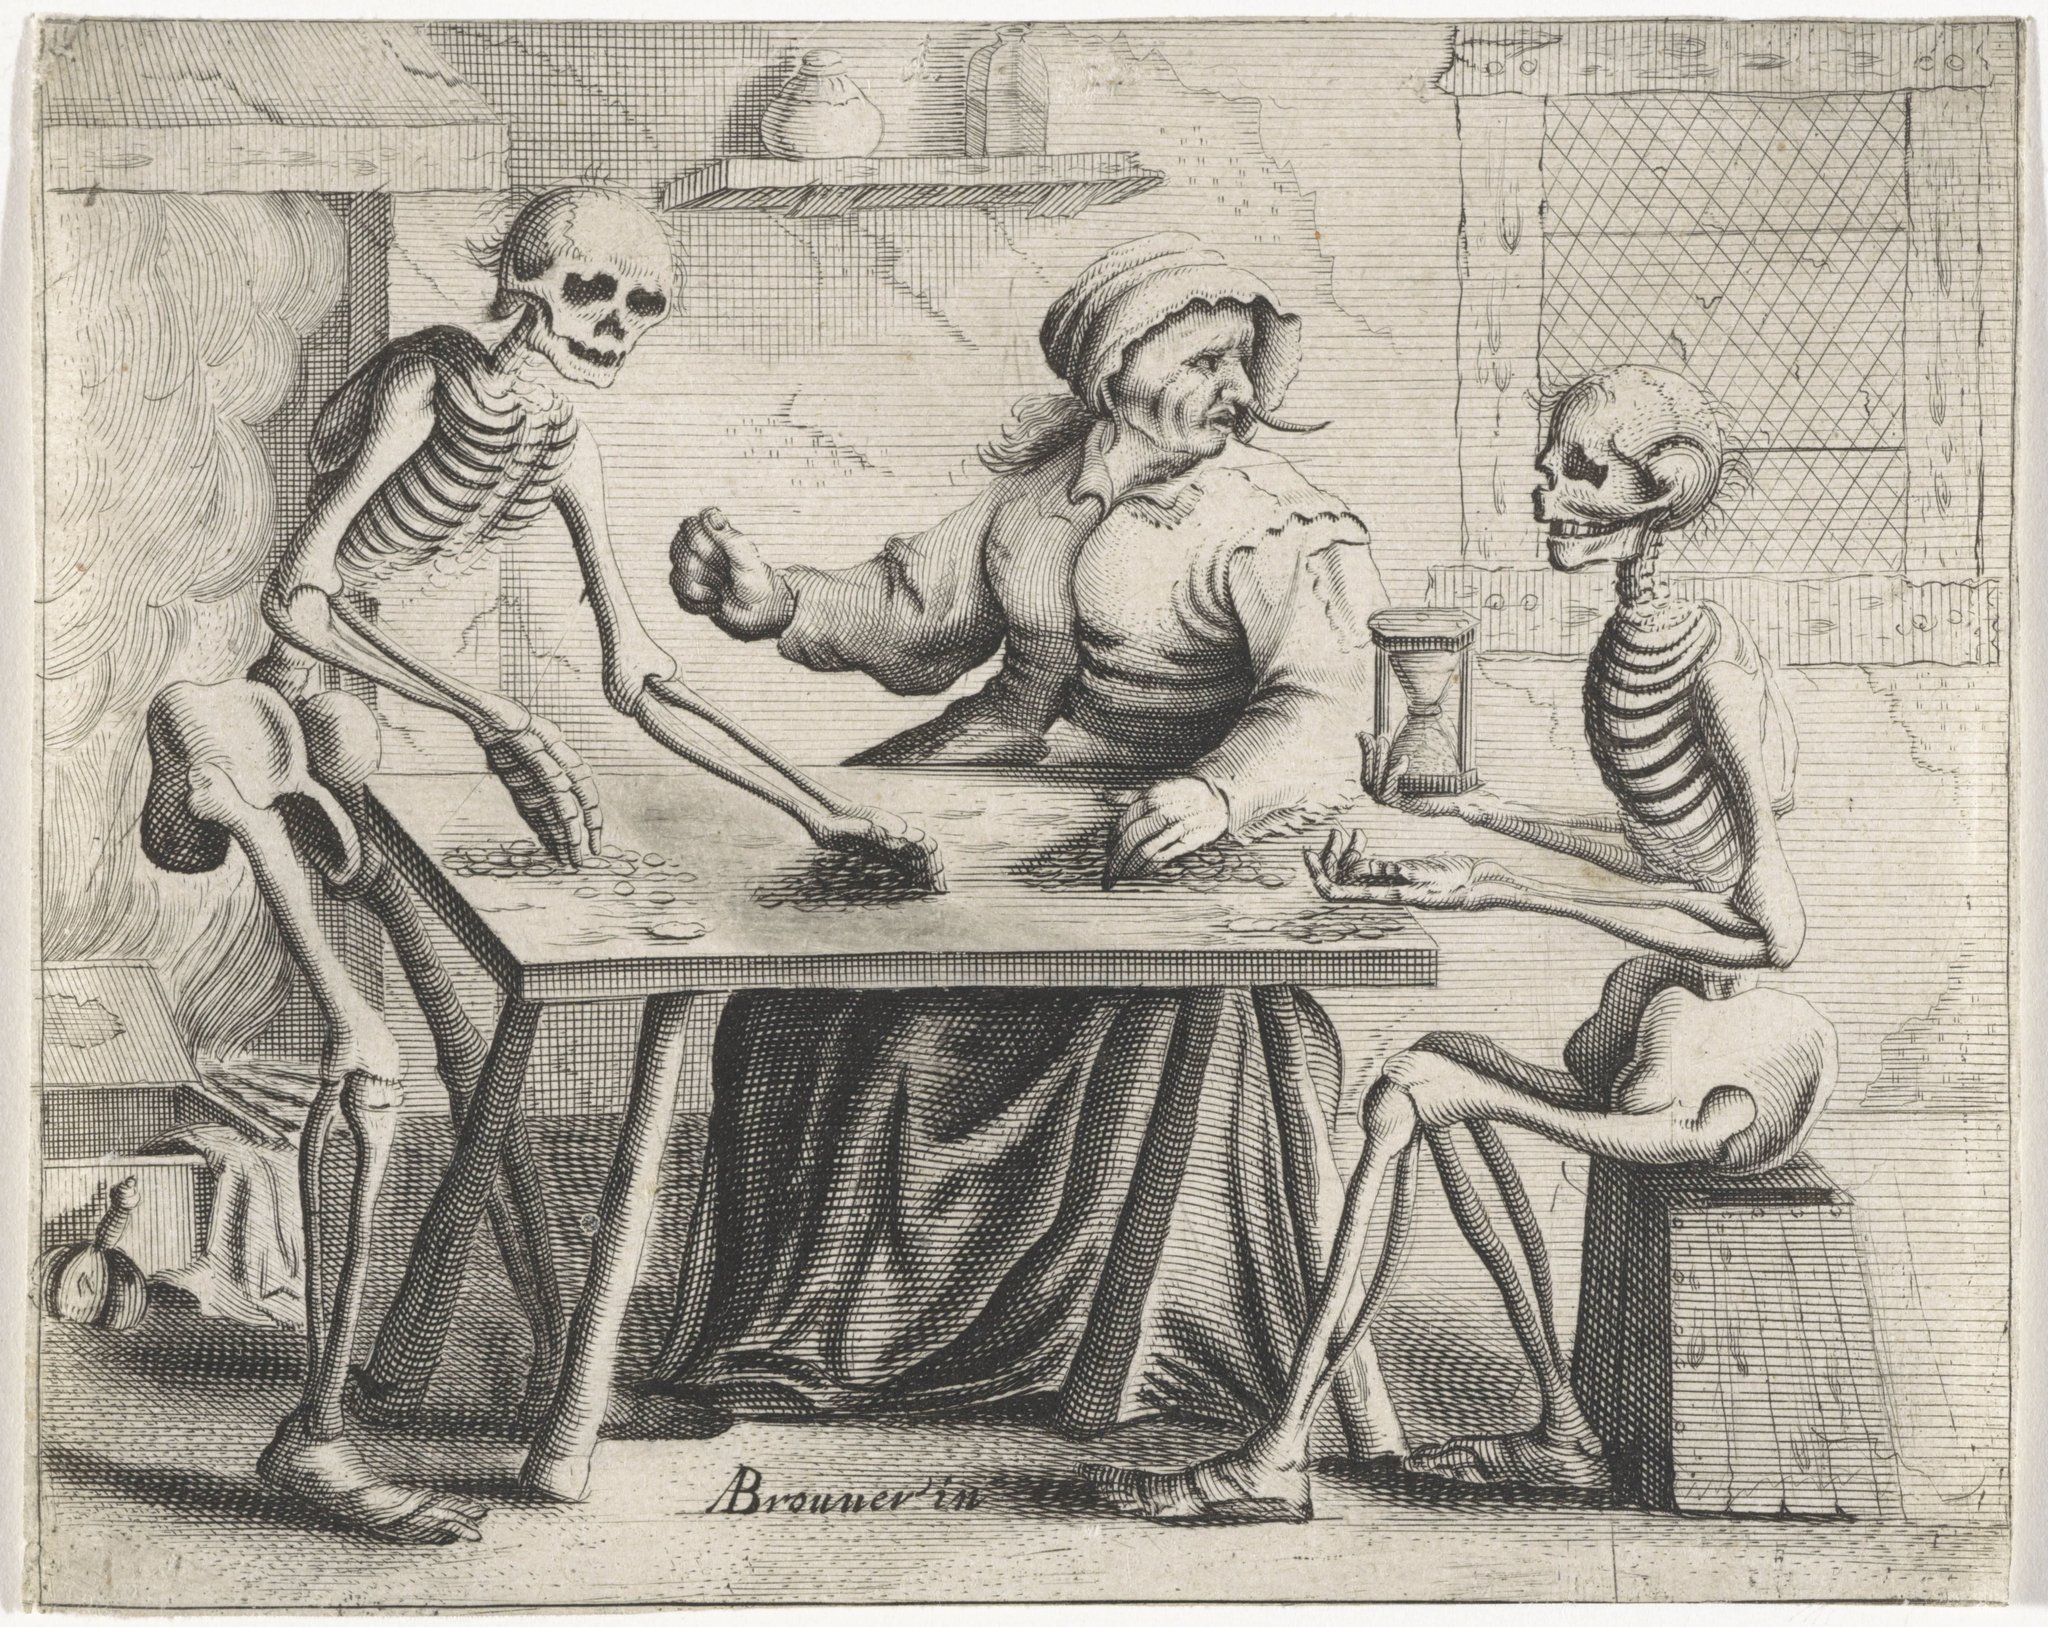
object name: print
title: Oude vrouw met twee skeletten aan tafel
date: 1622-1688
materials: paper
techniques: engraving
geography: southern netherlands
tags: scenes symbolizing 'vanitas', old woman, hourglass, (human) skeleton, money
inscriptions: collector's mark: Lugt 2228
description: Een oude vrouw zit aan een tafel in een eenvoudig interieur met een brandende open haard. Haar linkerhand ligt op enkele munten. Aan het hoofd van de tafel zit een een skelet, de Dood, met een zandloper in zijn hand als vanitassymbool. Ook zijn hand rust op enkele munten. Tegenover hem staat een tweede skelet. Hij schuift enkele munten naar zich toe.